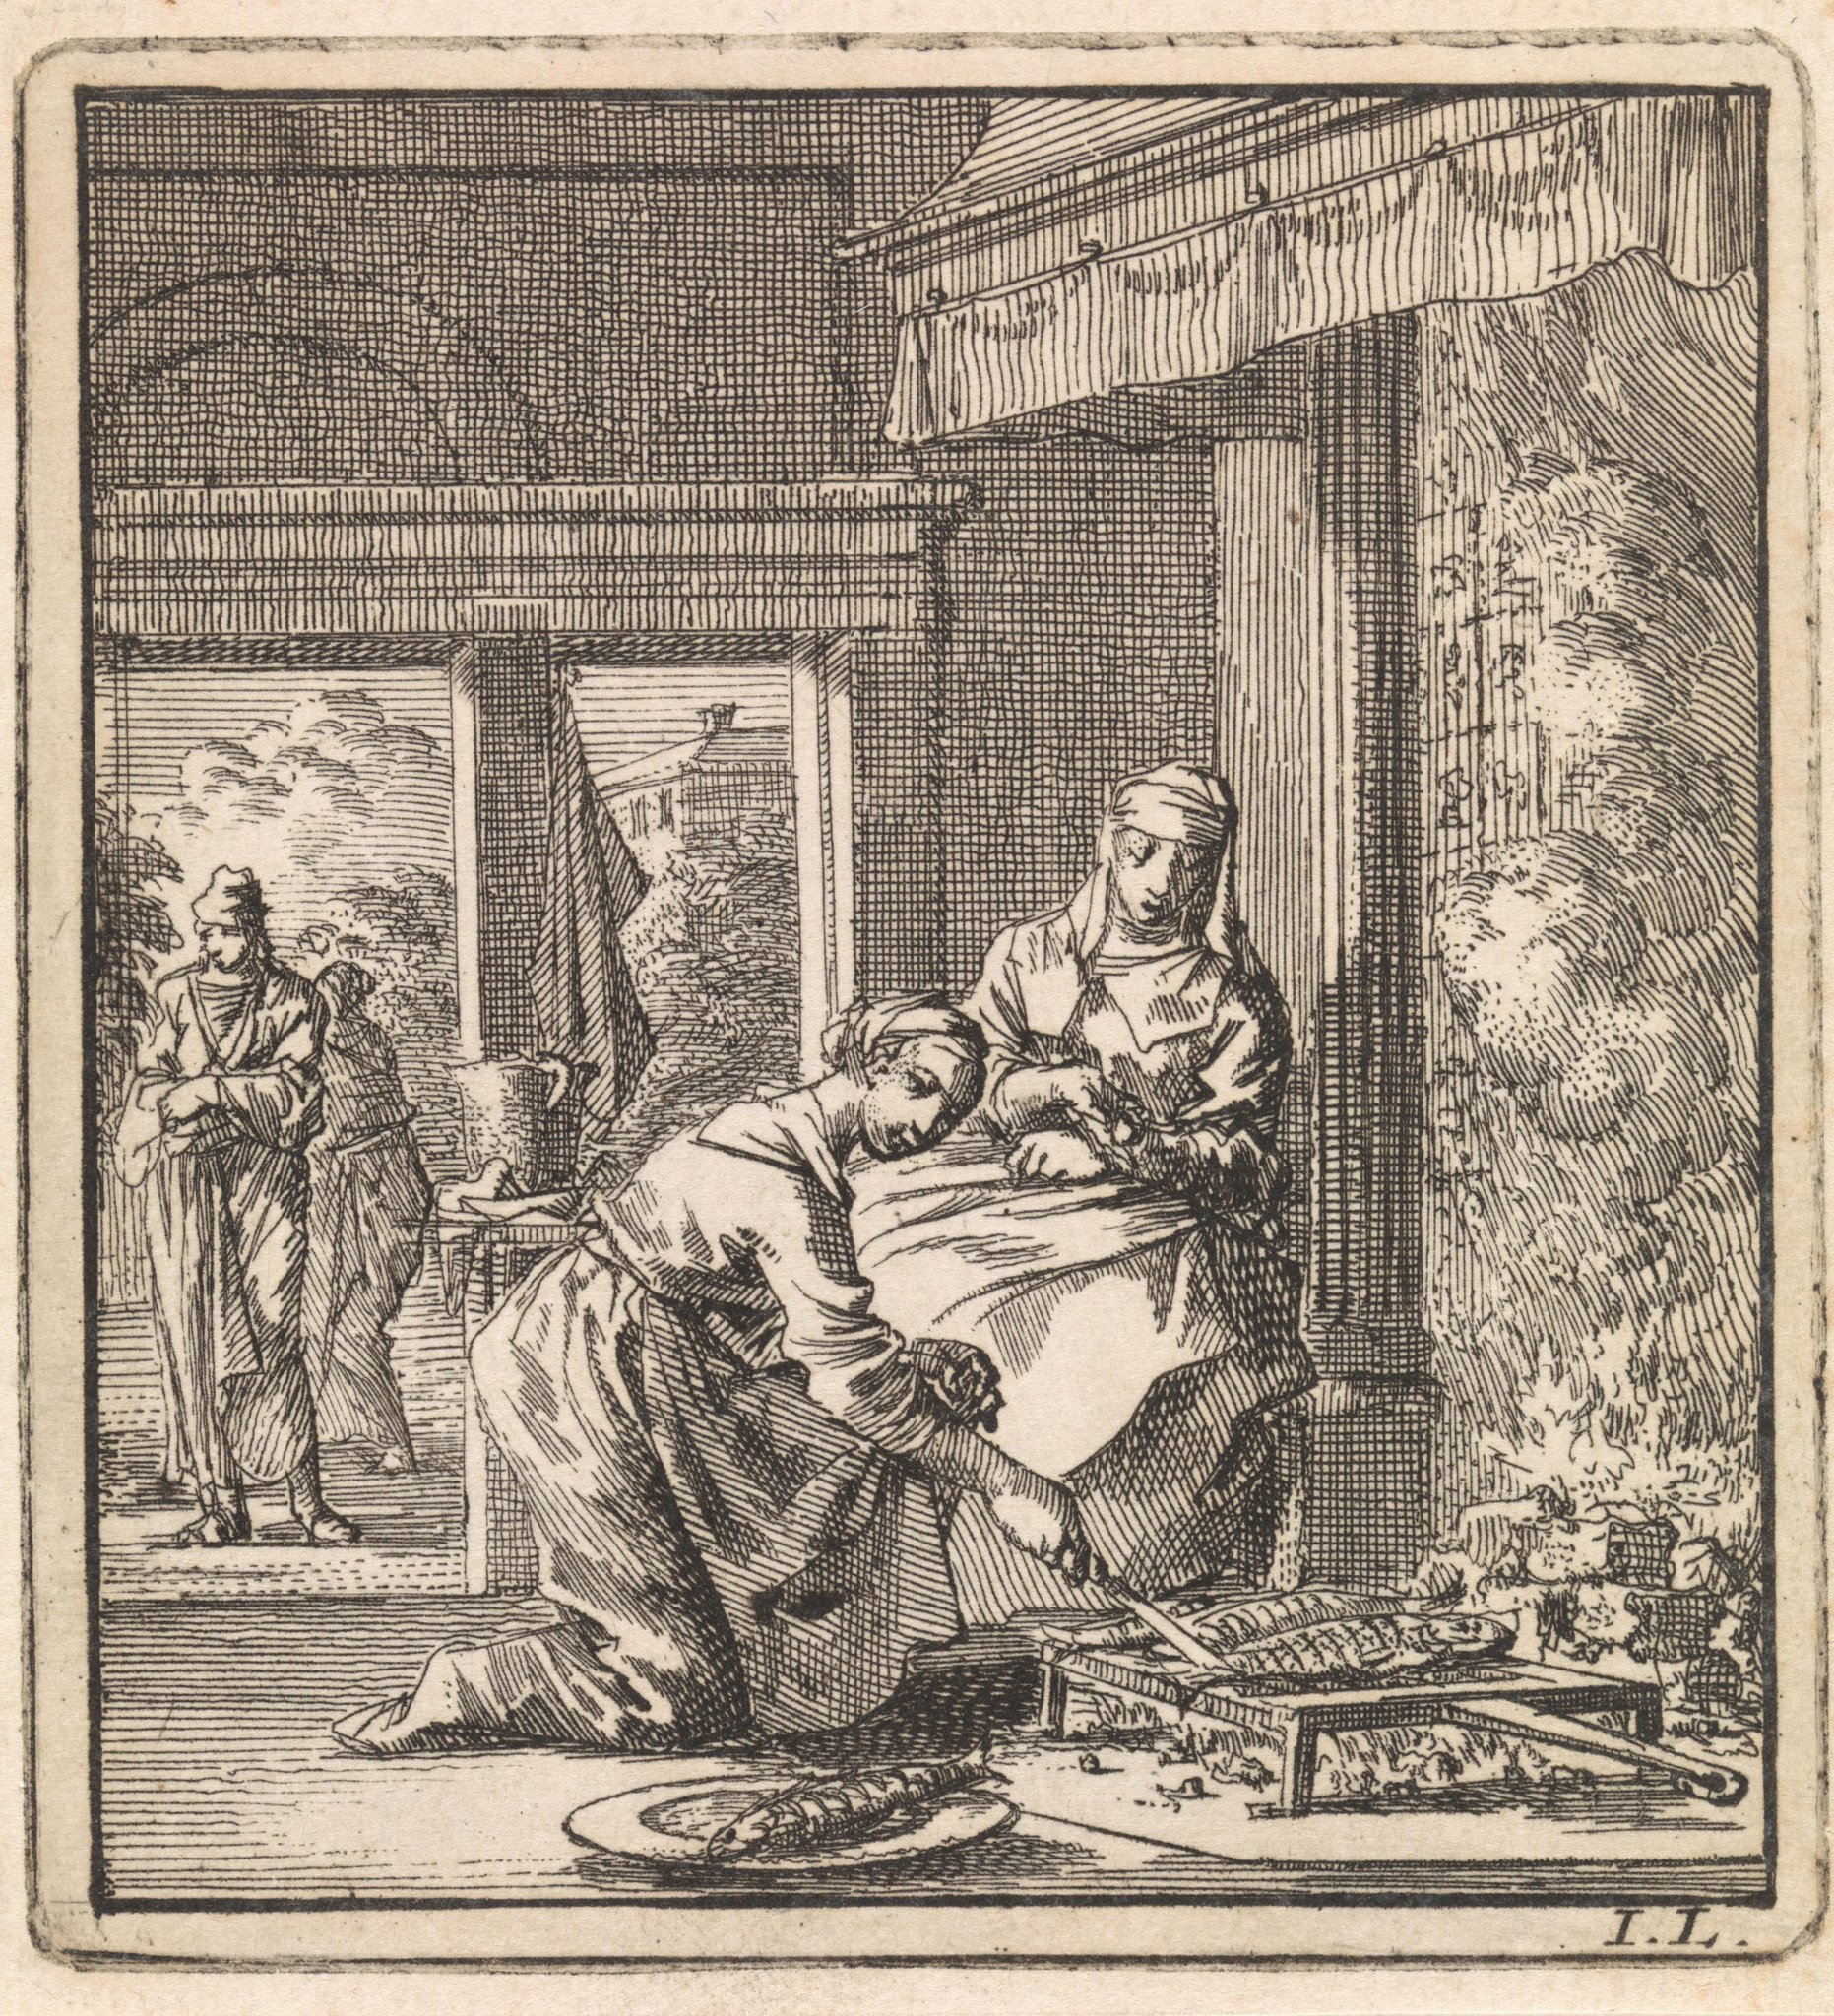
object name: book illustration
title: Twee vrouwen bakken vis op het haardvuur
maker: jan luyken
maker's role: draughtsman, print maker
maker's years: 1649-1712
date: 1711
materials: paper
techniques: etching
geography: amsterdam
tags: chimney, roasting, grilling, fishes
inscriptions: collector's mark: Lugt 2228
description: Illustratie voor: Luyken, Jan. Het leerzaam huisraad, vertoond in vyftig konstige figuuren, met godlyke spreuken en stichtelyke verzen: Pieter Arentsz. II (wed.) en Cornelis van der Sys, 1711, p. 134.